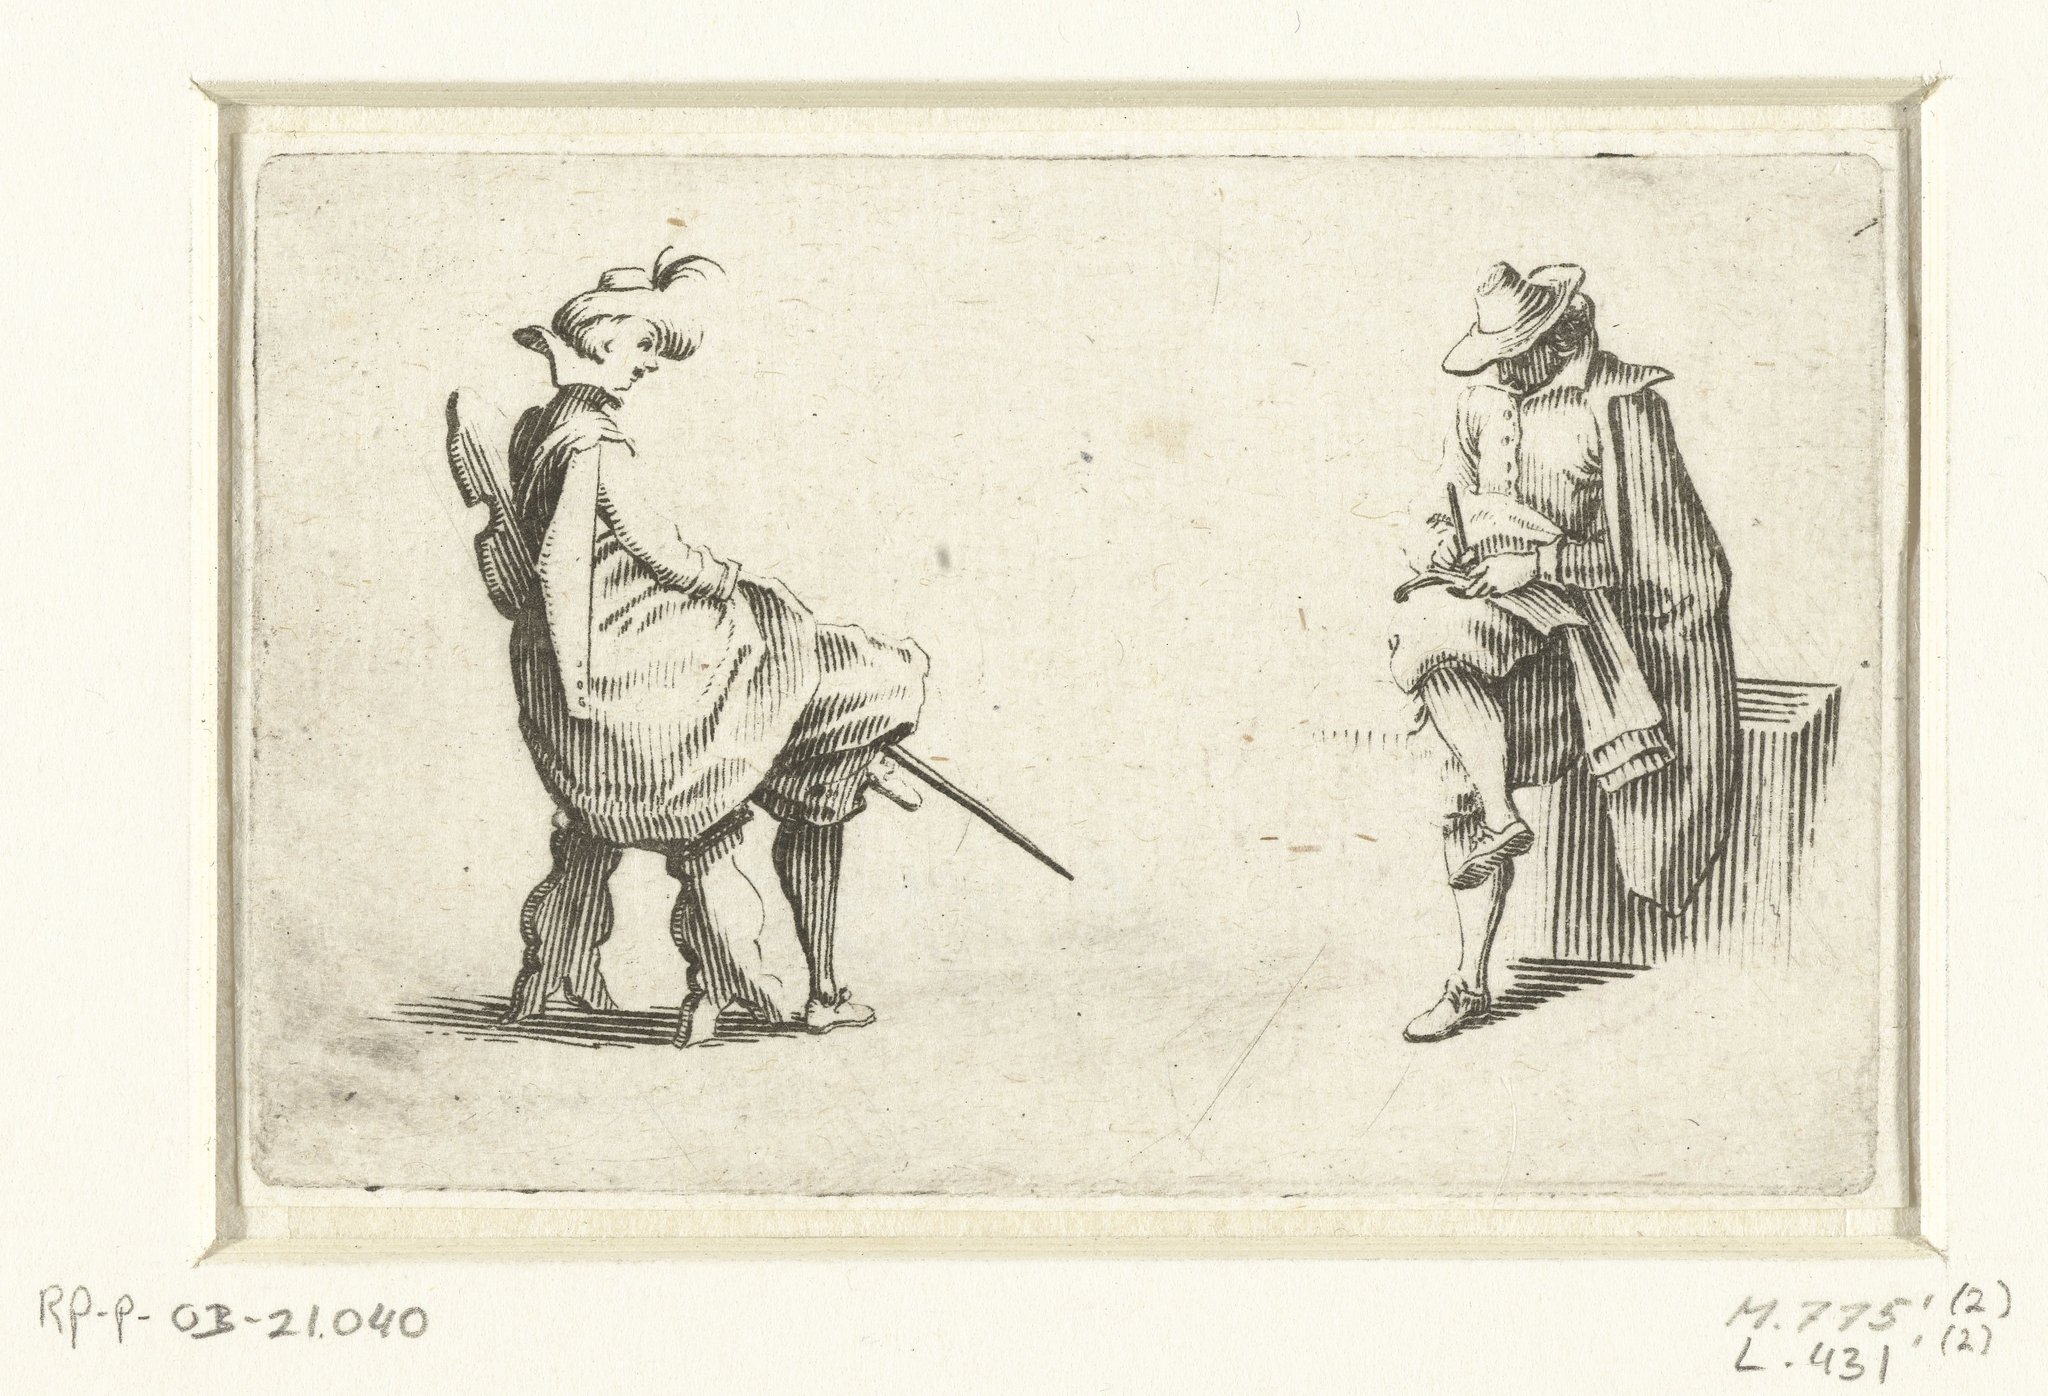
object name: print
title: Twee zittende mannen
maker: jacques callot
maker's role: draughtsman, print maker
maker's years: 1592-1635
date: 1621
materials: paper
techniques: etching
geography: nancy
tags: handwriting, writing as activity, the (nude) human figure; 'corpo humano' (ripa) (+ sitting), head-gear: hat (+ men's clothes), chair, sitting on an elevation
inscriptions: collector's mark: Lugt 240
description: Links een heer gezeten op een stoel, op de rechterzijde gezien. Rechts een man gezeten op een kist of muurtje, schrijvend, van voren gezien. Beiden dragen een hoed. Deze prent is onderdeel van een serie van 48 prenten (50 incl. titelblad en dedicatieblad) met diverse onderwerpen (o.a. mannen en vrouwen in verschillende houdingen, landschappen, gebouwen en festiviteiten in Florence). Mogelijk zijn deze prenten bedoeld geweest als tekenvoorbeelden.